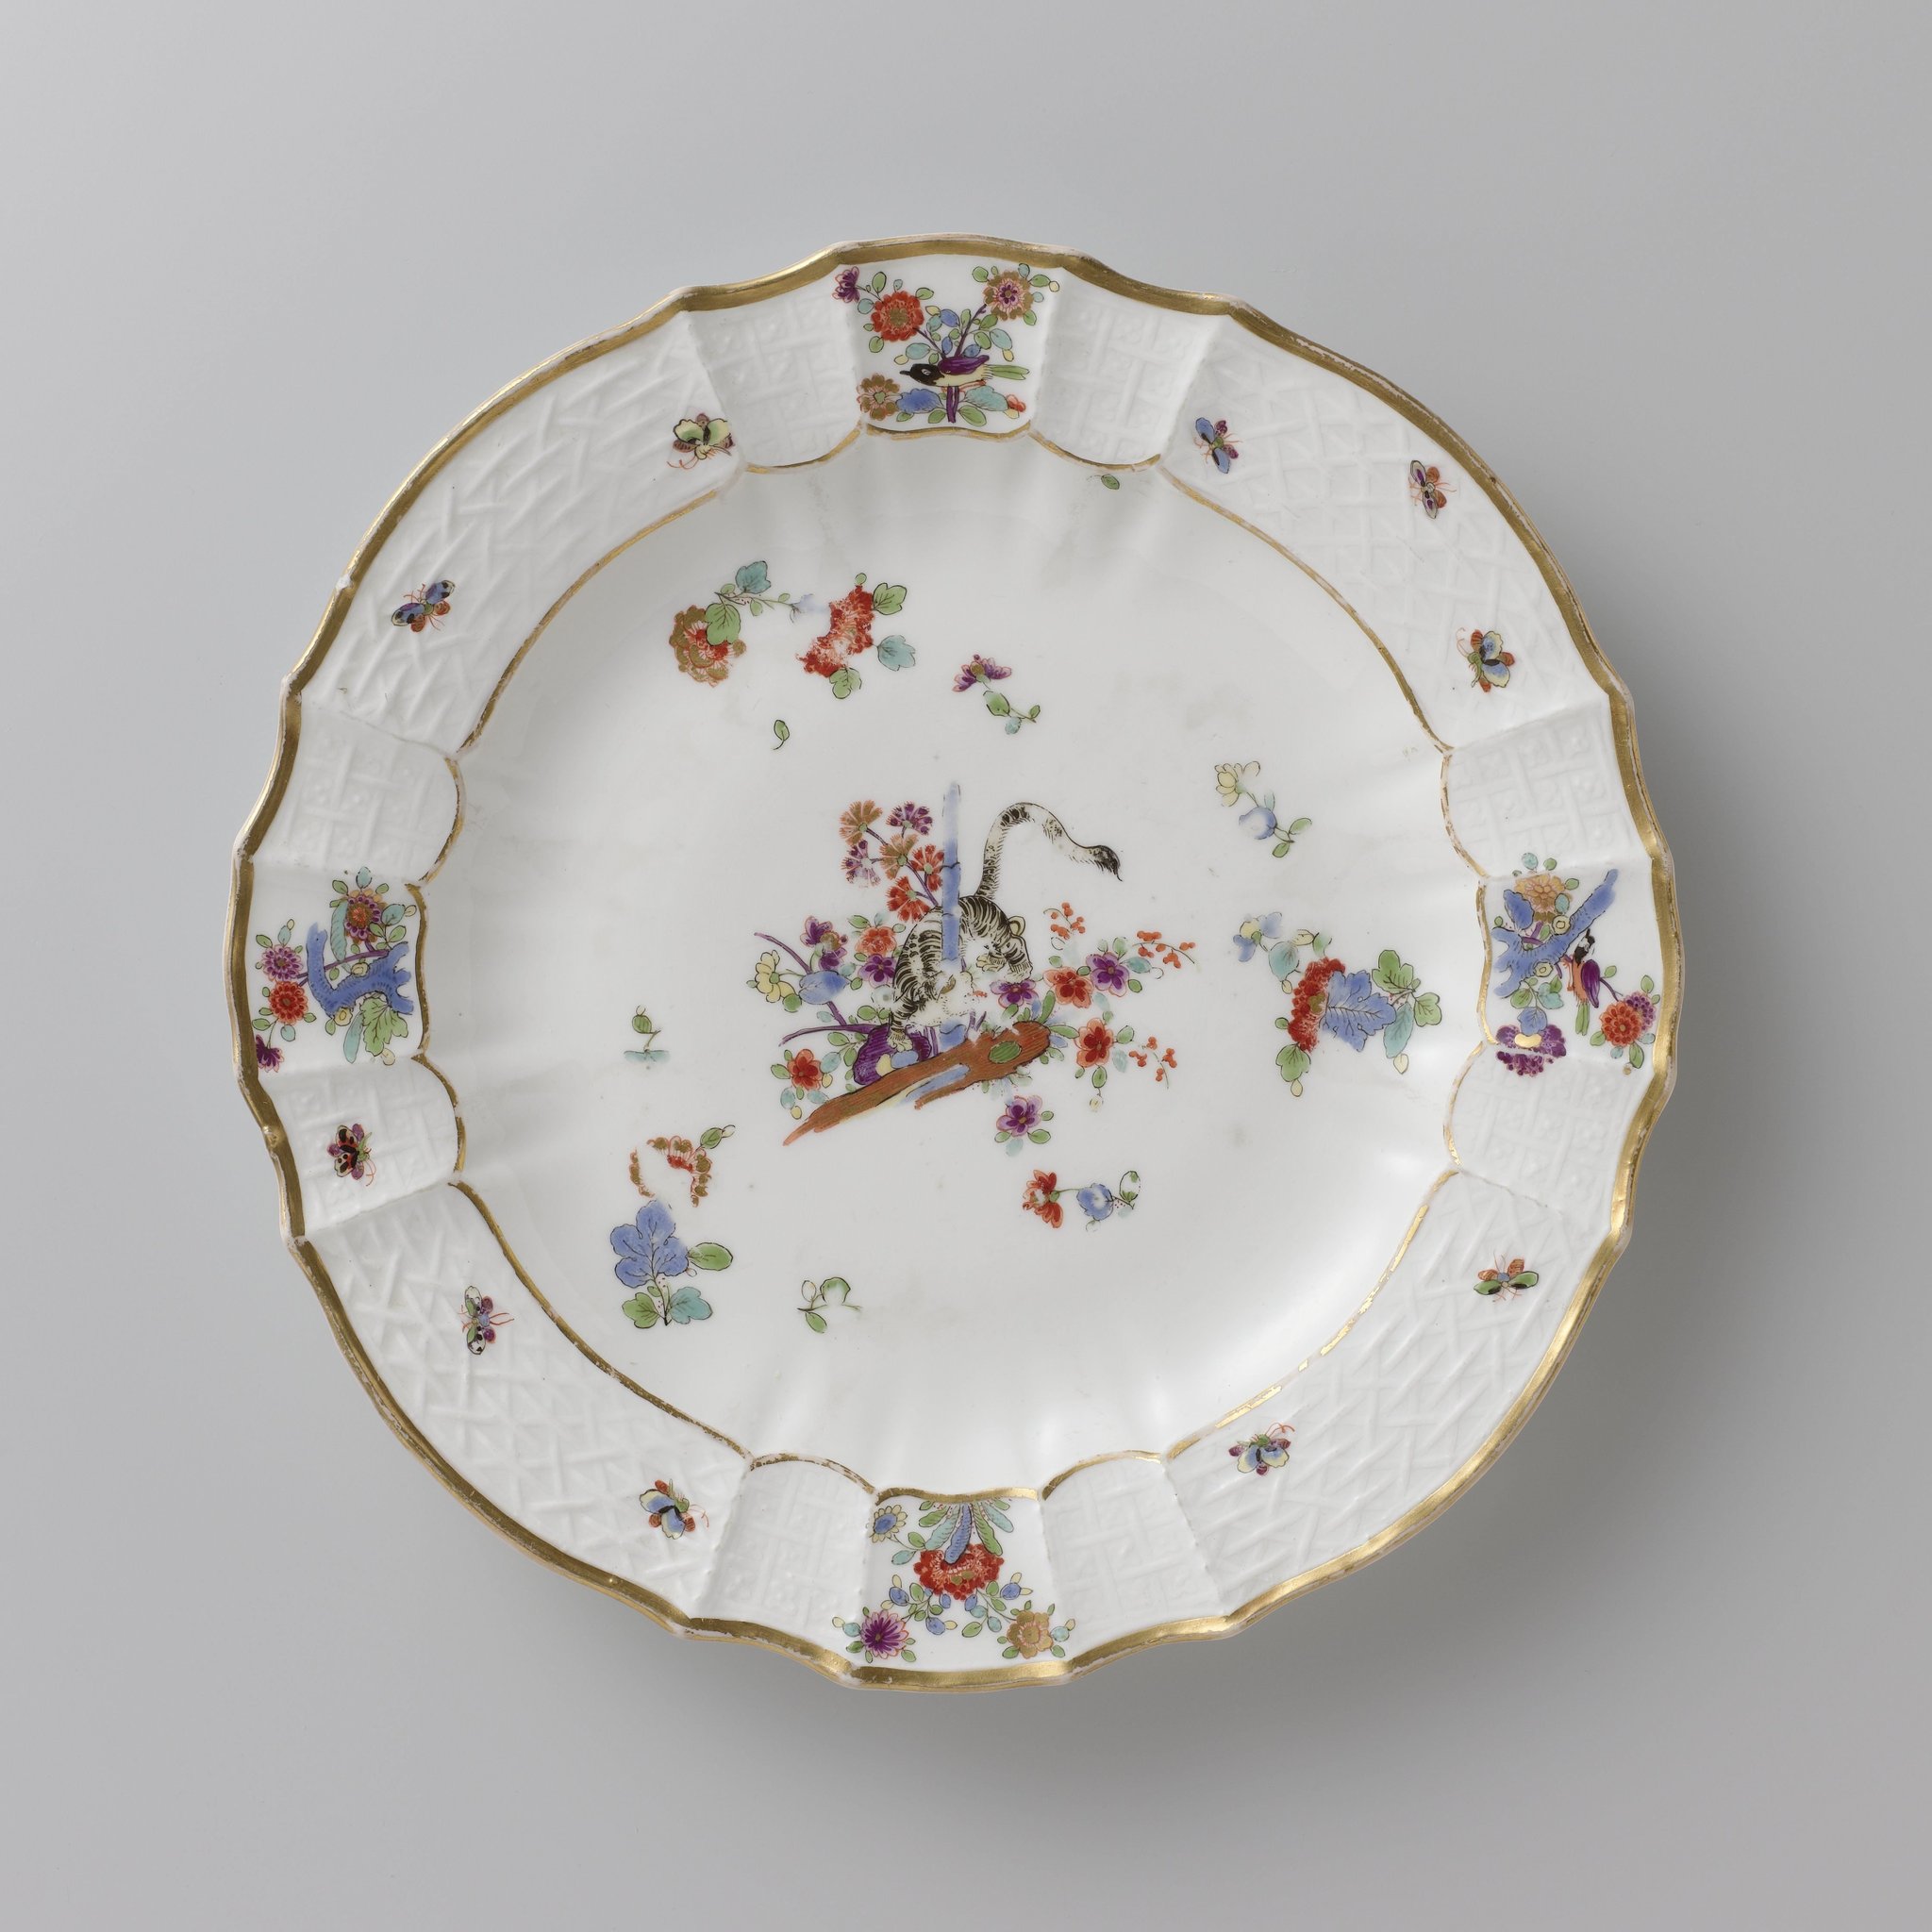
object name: plate dish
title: Rond bord, veelkleurig beschilderd met een Kakiemon-decor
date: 1740-1745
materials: porcelain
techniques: painted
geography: meissen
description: Rond bord van beschilderd porselein. Het bord is geribd en heeft een geschulpte rand. Het bord is beschilderd met een tijger die om een blauwe bamboestengel tussen bloemen is gedraaid, gestrooide Indianische Blumen, vlinders en takken waarop vogels. De rand is versierd met het 'Altbrandenstein'-patroon. Het bord is gemerkt.